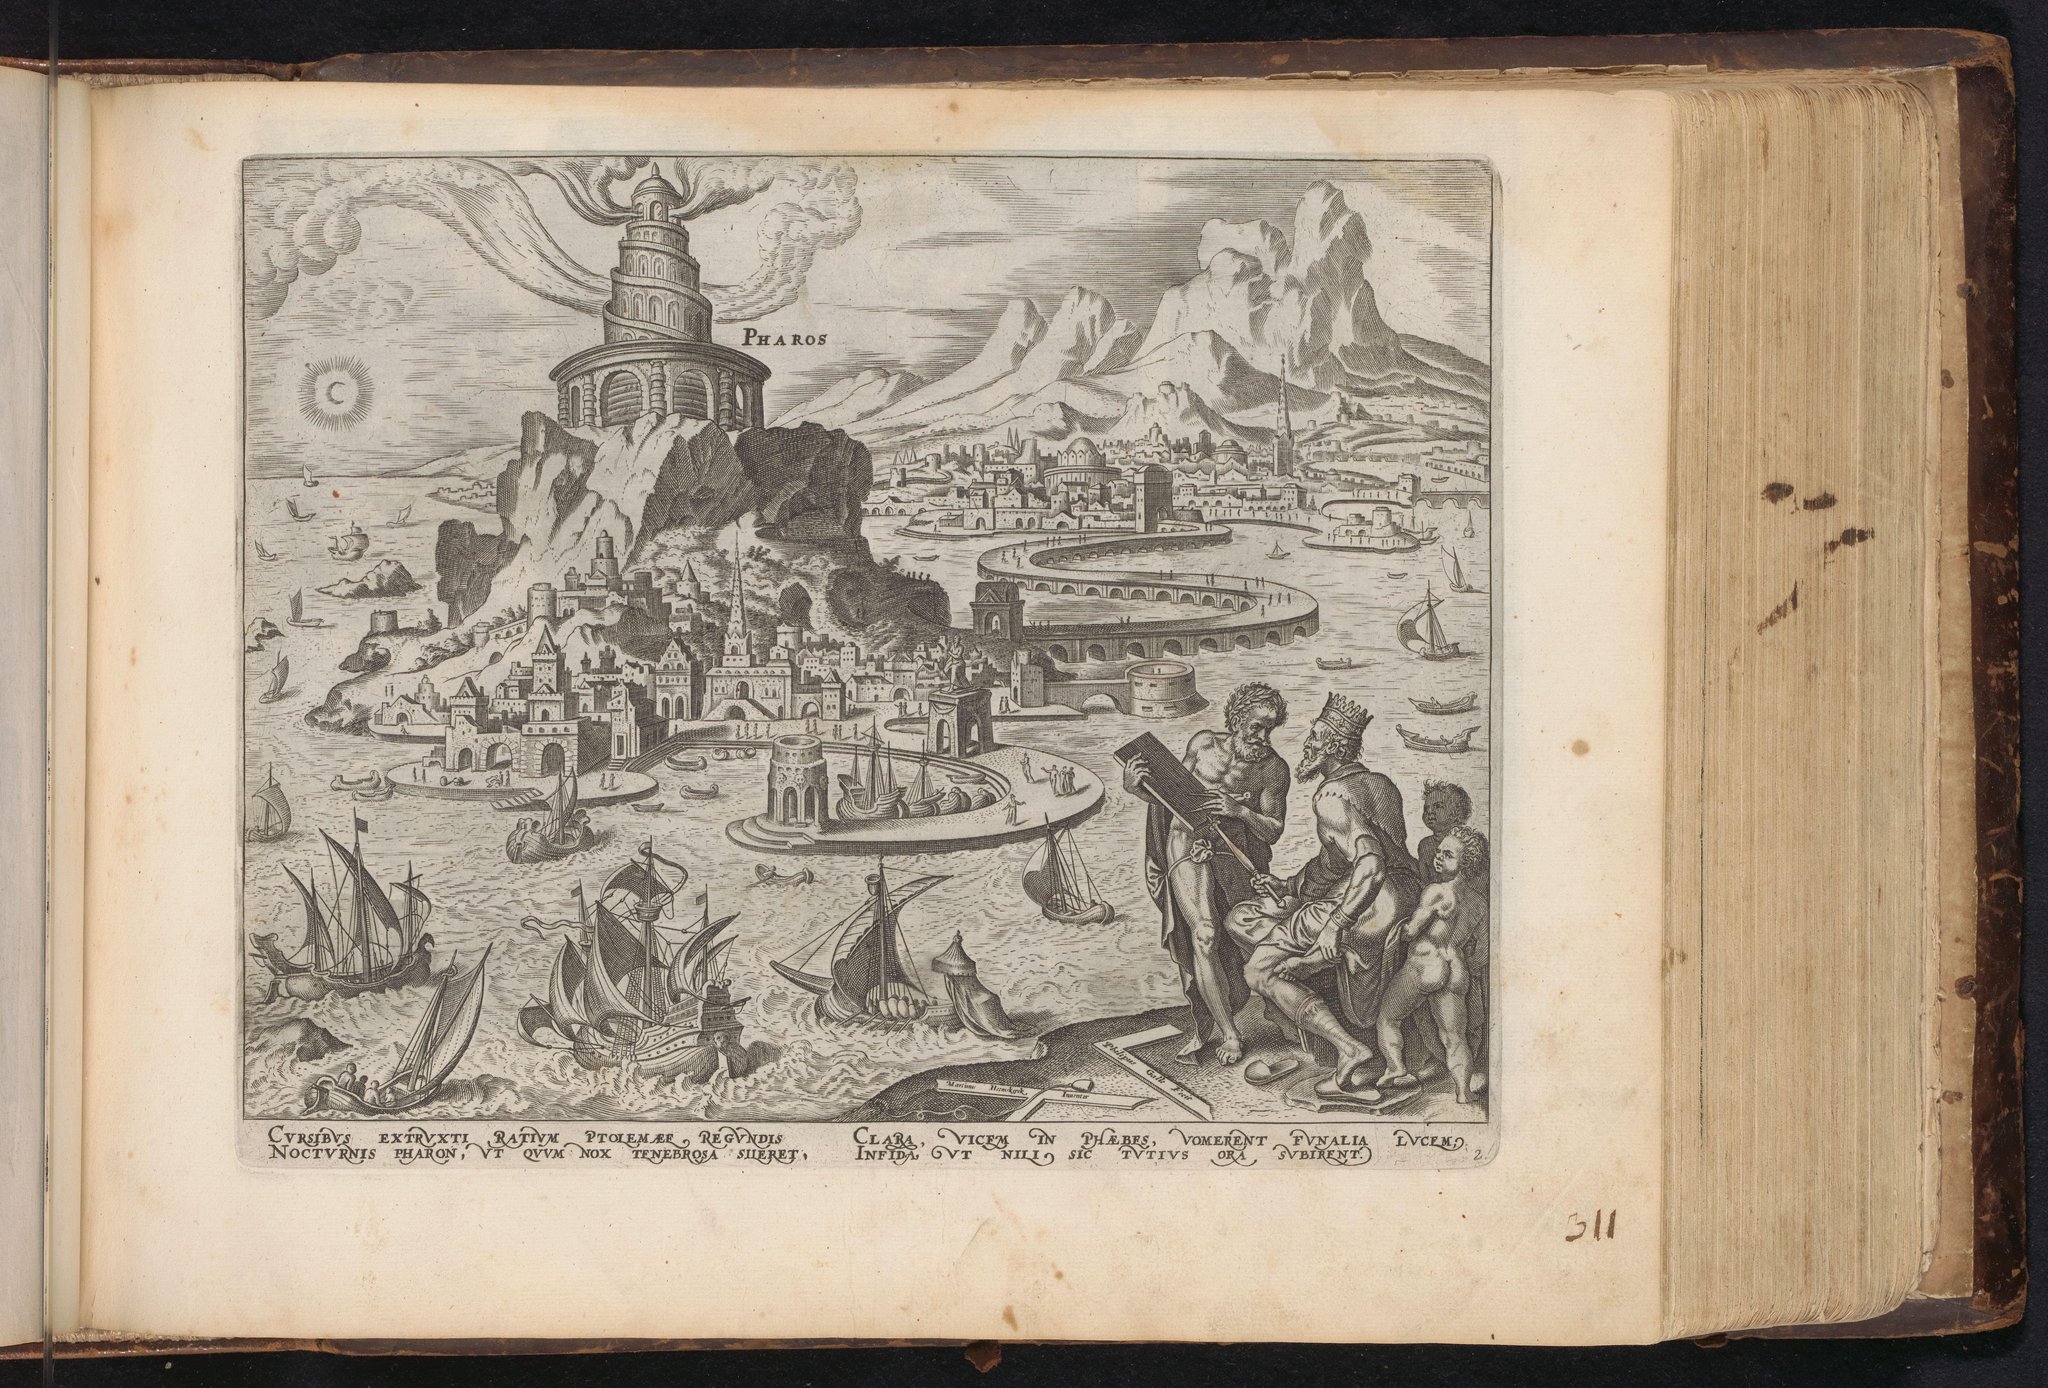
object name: album leaf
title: De acht wereldwonderen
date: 1572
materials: paper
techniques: engraving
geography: antwerp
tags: lighthouse, lightship, island (in tropical and sub-tropical regions), non-aggressive activities of ptolemy philadelphus, pharos of alexandria (wonder of the world)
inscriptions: number: ‘311’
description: De vuurtoren van de stad Alexandrië. Voorzover bekend de eerste vuurtoren die ooit werd gebouwd. Dit gebeurde in opdracht van de eerste hellenistische koning van Egypte Ptolemaeus II. De toren werd tussen 297 en 283 v. Chr. gebouwd en heeft bijna 1500 jaar dienst gedaan voor achtereenvolgens de Grieken, Romeinen, Byzantijnen en Arabieren. Hij stond op het eiland Pharos in de Middellandse Zee, net buiten de haven van het Egyptische Alexandrië. In de voorgrond rechts Ptolemaeus II en de architect van de vuurtoren, Sostratus van Knidos. Onder de voorstelling een vers in het Latijn. Deze prent maakt deel uit van een album.